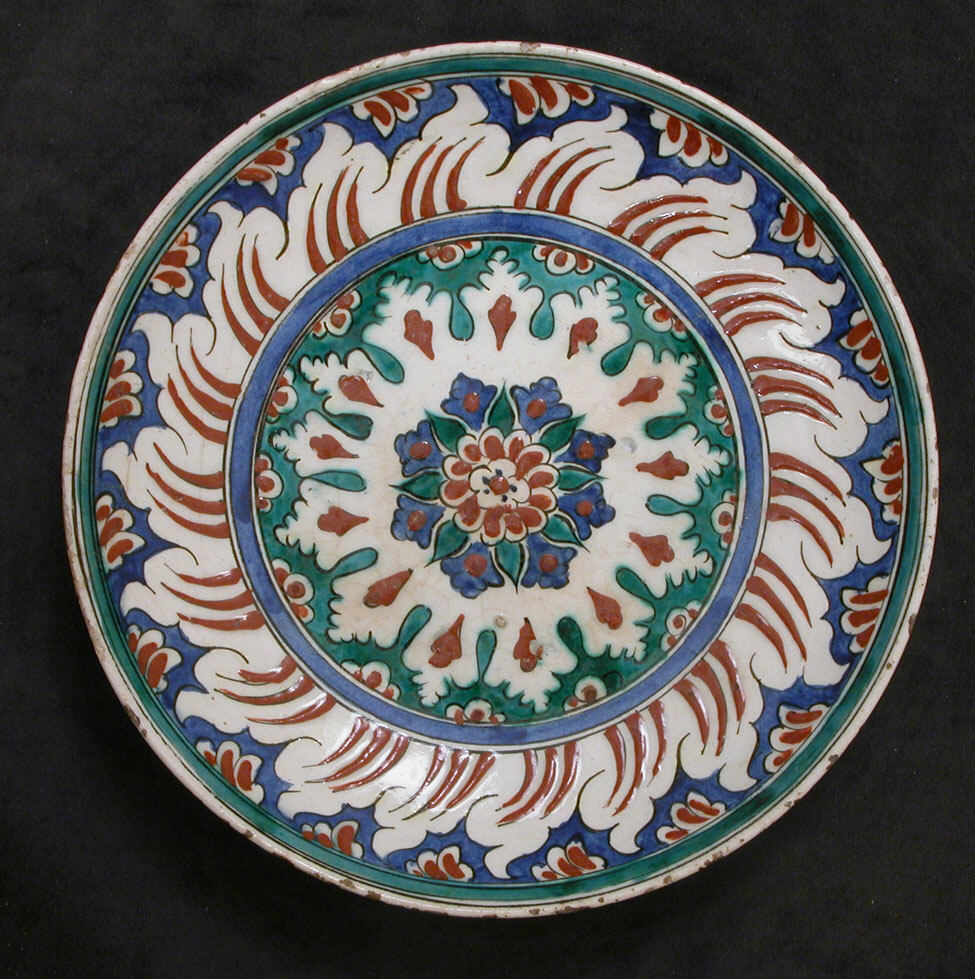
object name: dish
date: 1576-1600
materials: stonepaste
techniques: glazing, painting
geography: turkey